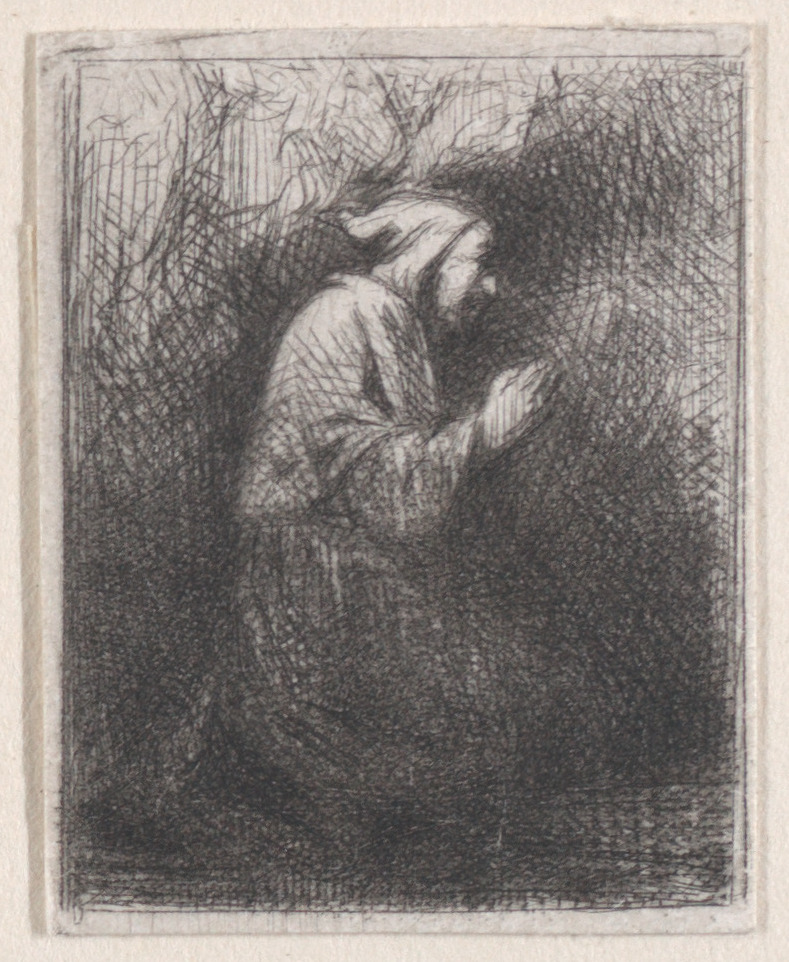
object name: print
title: Praying Monk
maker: charles émile jacque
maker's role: artist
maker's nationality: french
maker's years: 1813-1894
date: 1843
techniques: drypoint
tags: men,monks,praying